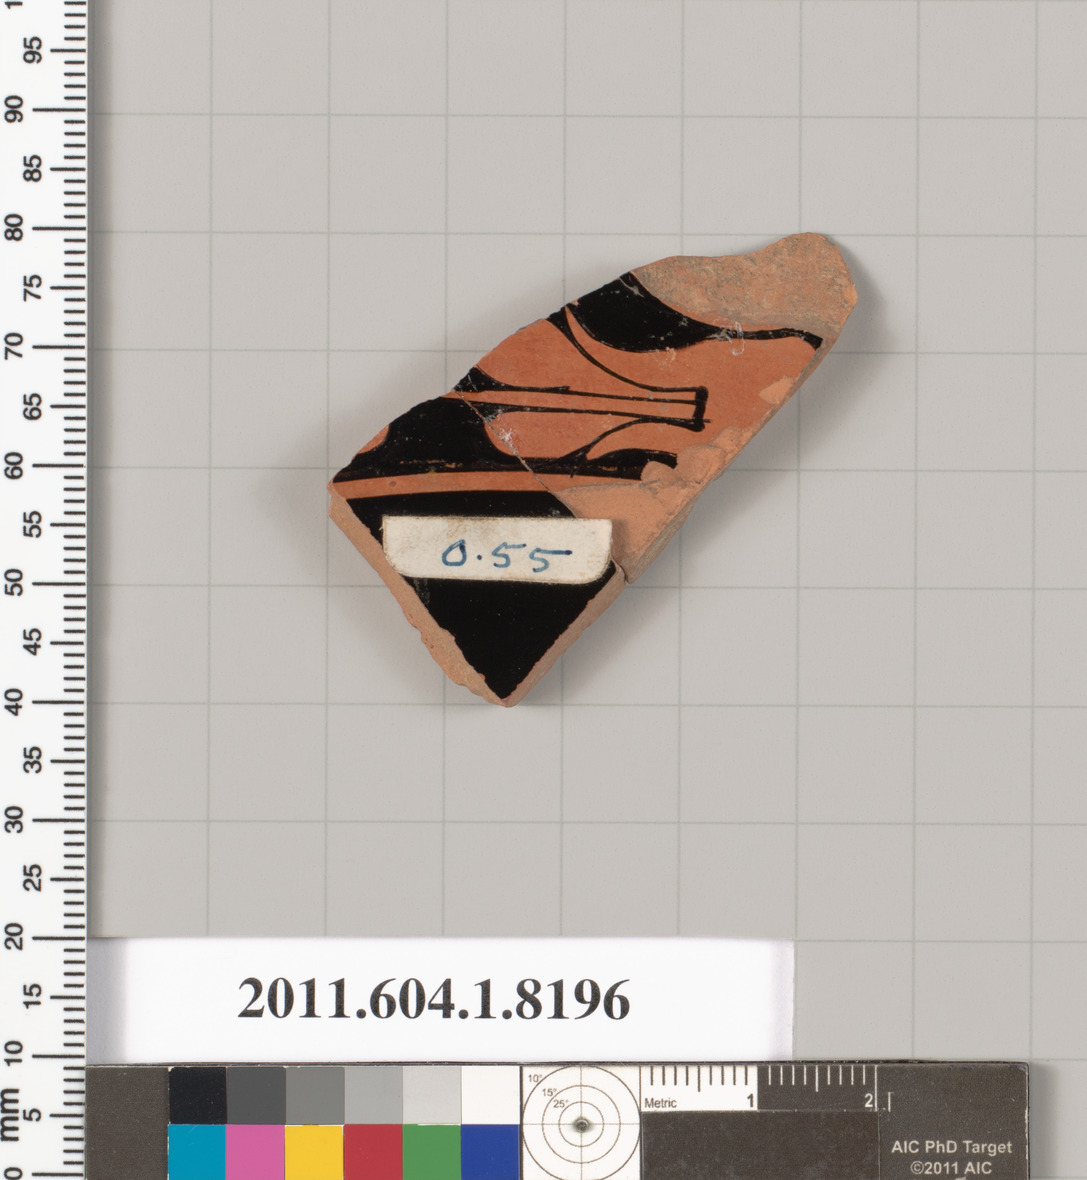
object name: kylix fragment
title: Terracotta fragment of a kylix (drinking cup)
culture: greek, attic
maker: oltos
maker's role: artist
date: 520-510 BCE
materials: terracotta